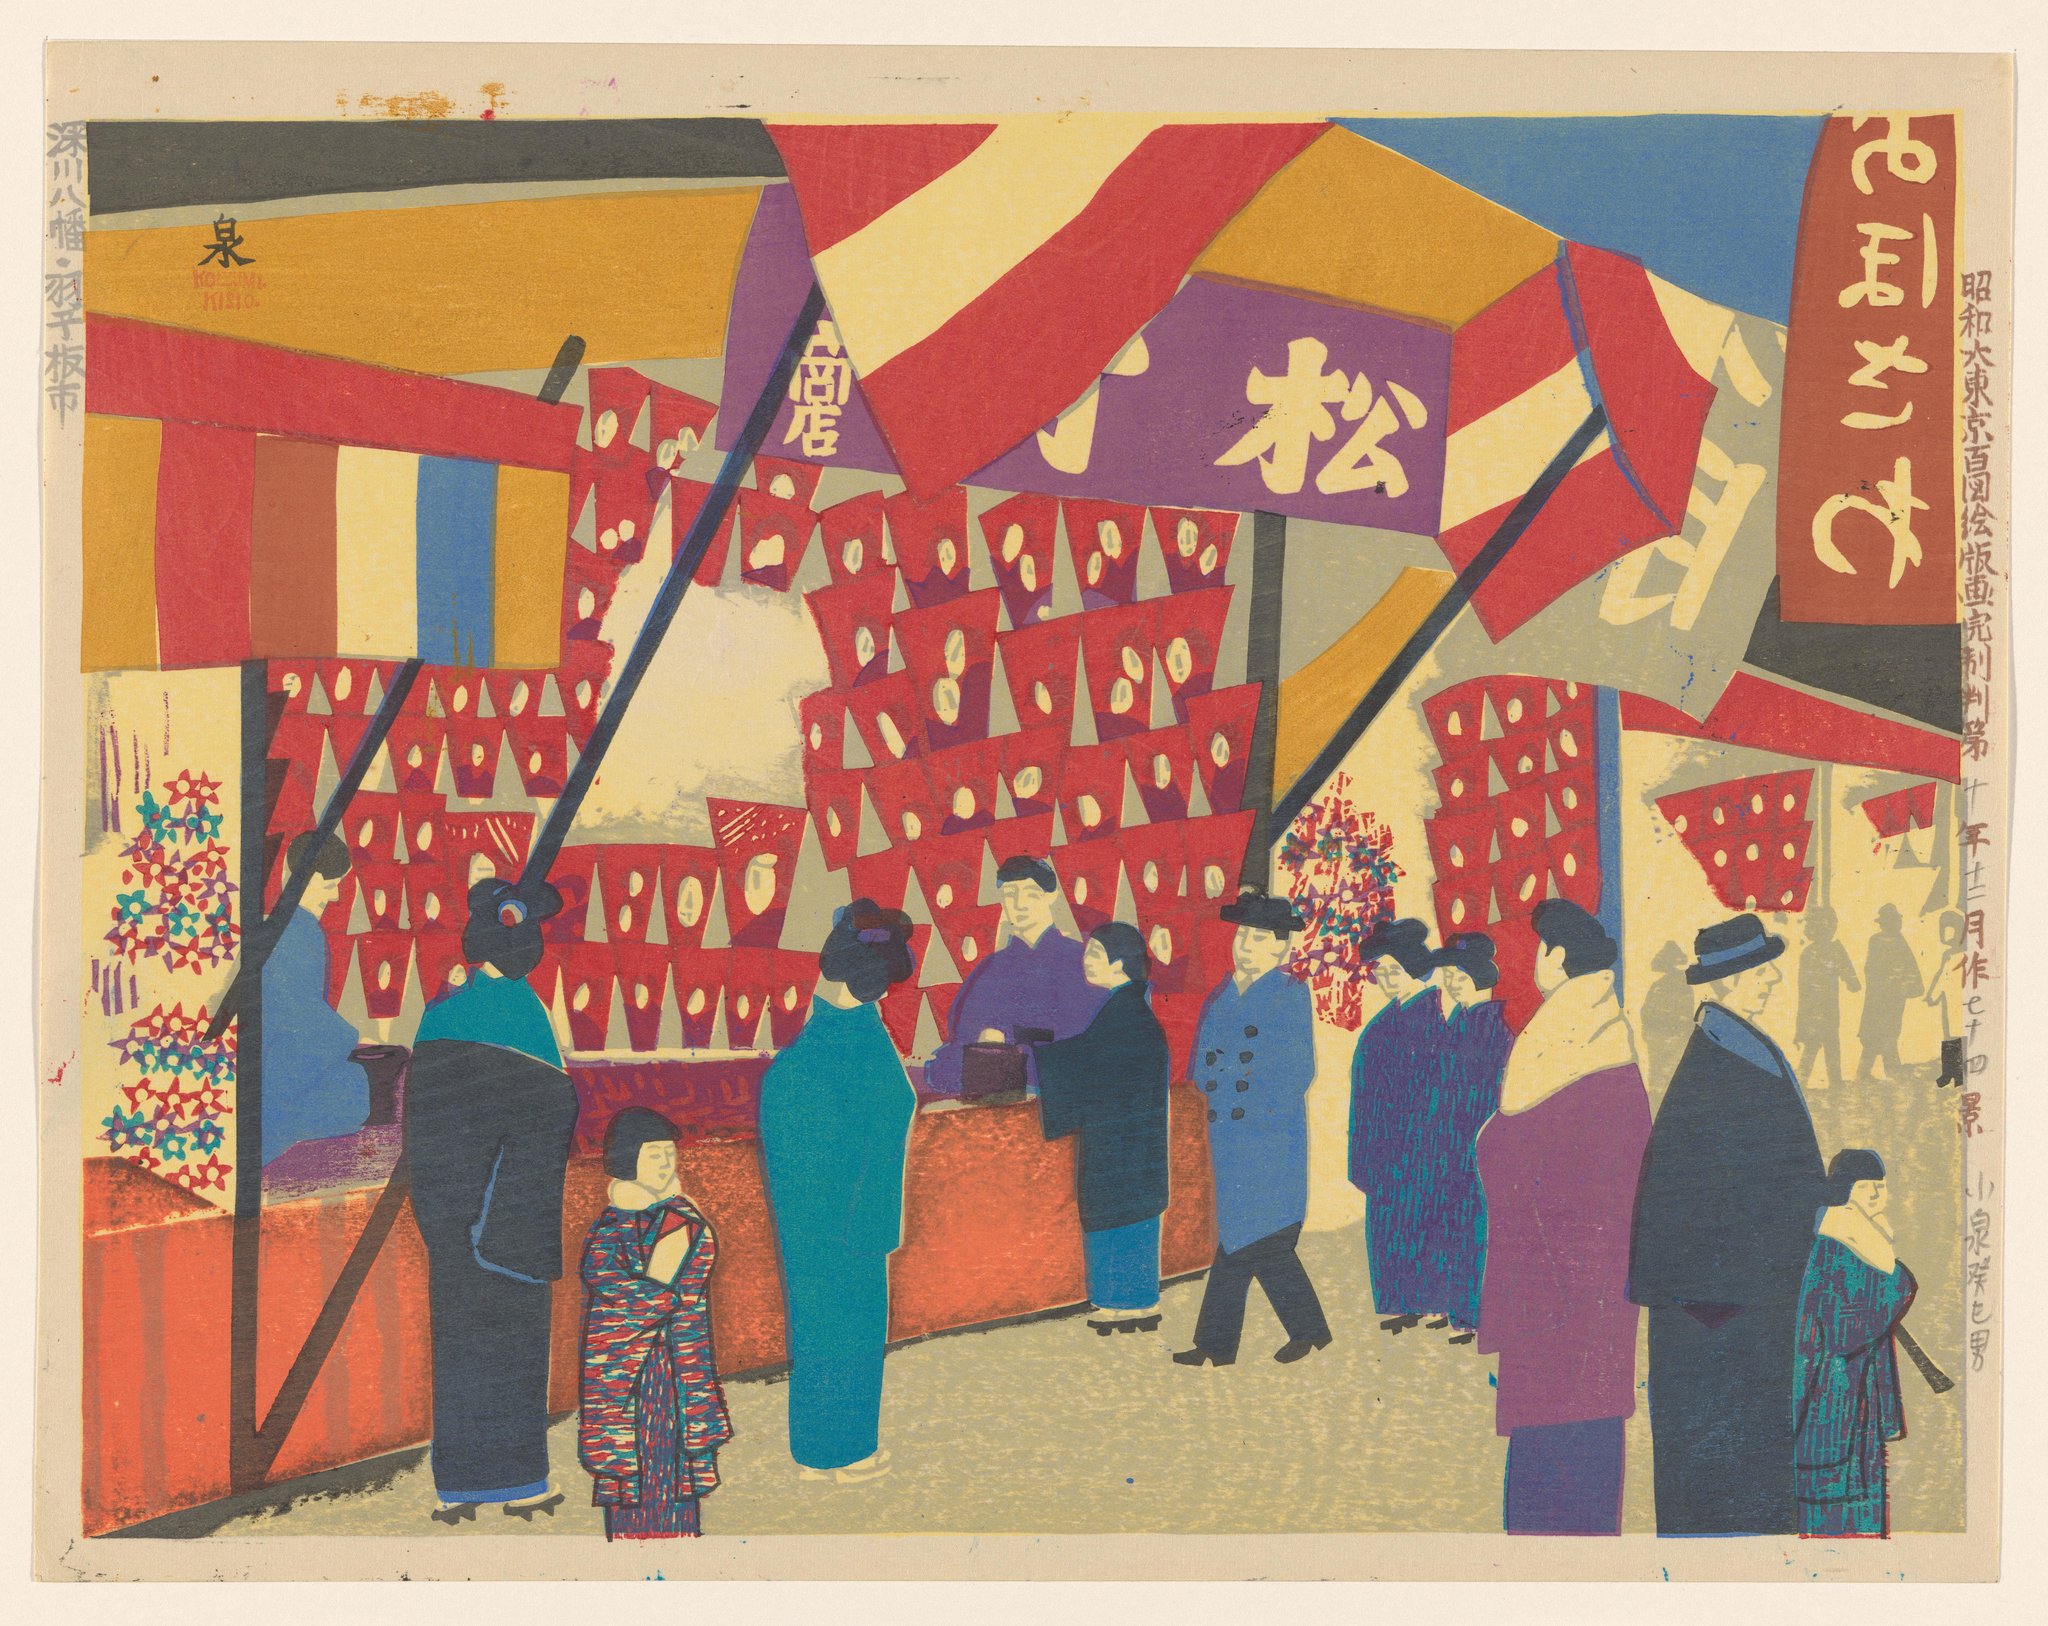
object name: print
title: One hundred pictures of Great Tokyo in the Shōwa era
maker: koizumi kishio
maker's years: 1893-1945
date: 1912-1935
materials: paper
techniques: woodcut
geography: japan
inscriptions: signature: ‘小泉癸巳男’, signature: ‘泉’, seal: ‘Koizumi Kishio.’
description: Volwassenen en kinderen gekleed in warme kimono bezoeken het festival bij het Fukagawa Hachiman-heiligdom, waar verschillende kraampjes hagoita-rackets verkopen. Hagoita is een soort badminton dat vooral rond de jaarwisseling werd gespeeld. In september 1928 begon Koizumi Kishio aan zijn ambitieuze plan om honderd landschapsprenten met scènes in Tokyo volledig zelf te ontwerpen, hiervan zelf de drukblokken te snijden en zelf de prenten te drukken. De aanleiding voor het project was grote verandering die Tokyo onderging door de verwoestende Grote Kantō-aardbeving van 1923 en de wederopbouw die daarop volgde. Kishio maakt een bewuste verwijzing naar de bekende serie ‘Honderd beroemde gezichten op Edo’ door Utagawa Hiroshige (1797–1858), met prenten van locaties in Edo—de oude benaming voor Tokyo. Kishio toont overwegend moderne gebouwen, instituten en mensen die de tijdsgeest van de jaren 1920 en 1930 weerspiegelen. Sommige prenten onthullen daarentegen een nostalgische blik op overblijfselen uit het oude Edo. Kishio verkocht de prenten aan de hand van een abonnement met een limiet van vijftig leden, die elke maand een of twee prenten zouden ontvangen. Het project begon met negen abonnementen, maar al na de tweede maand werden meerdere daarvan opgezegd en slechts vier mecenassen bleven lid tot en met de voltooiing van de serie. Hij bracht het honderdste ontwerp uit in 1937. Zijn leermeester Ishii Hakutei schreef een inleiding in 1938 die Kishio verwerkte tot een prent en toevoegde aan de set. Tussen 1939 en 1940 maakte hij nog eens negen extra ontwerpen. Met acht van deze ontwerpen verving hij oudere nummers uit de serie, mogelijk omdat hij niet tevreden was met de composities. Uiteindelijk lukte het Kishio om tien complete sets te verkopen aan de shin hanga-uitgever Watanabe Shōzaburō en liet hiervoor speciale houten dozen maken. Deze prent behoort tot een van die tien sets.